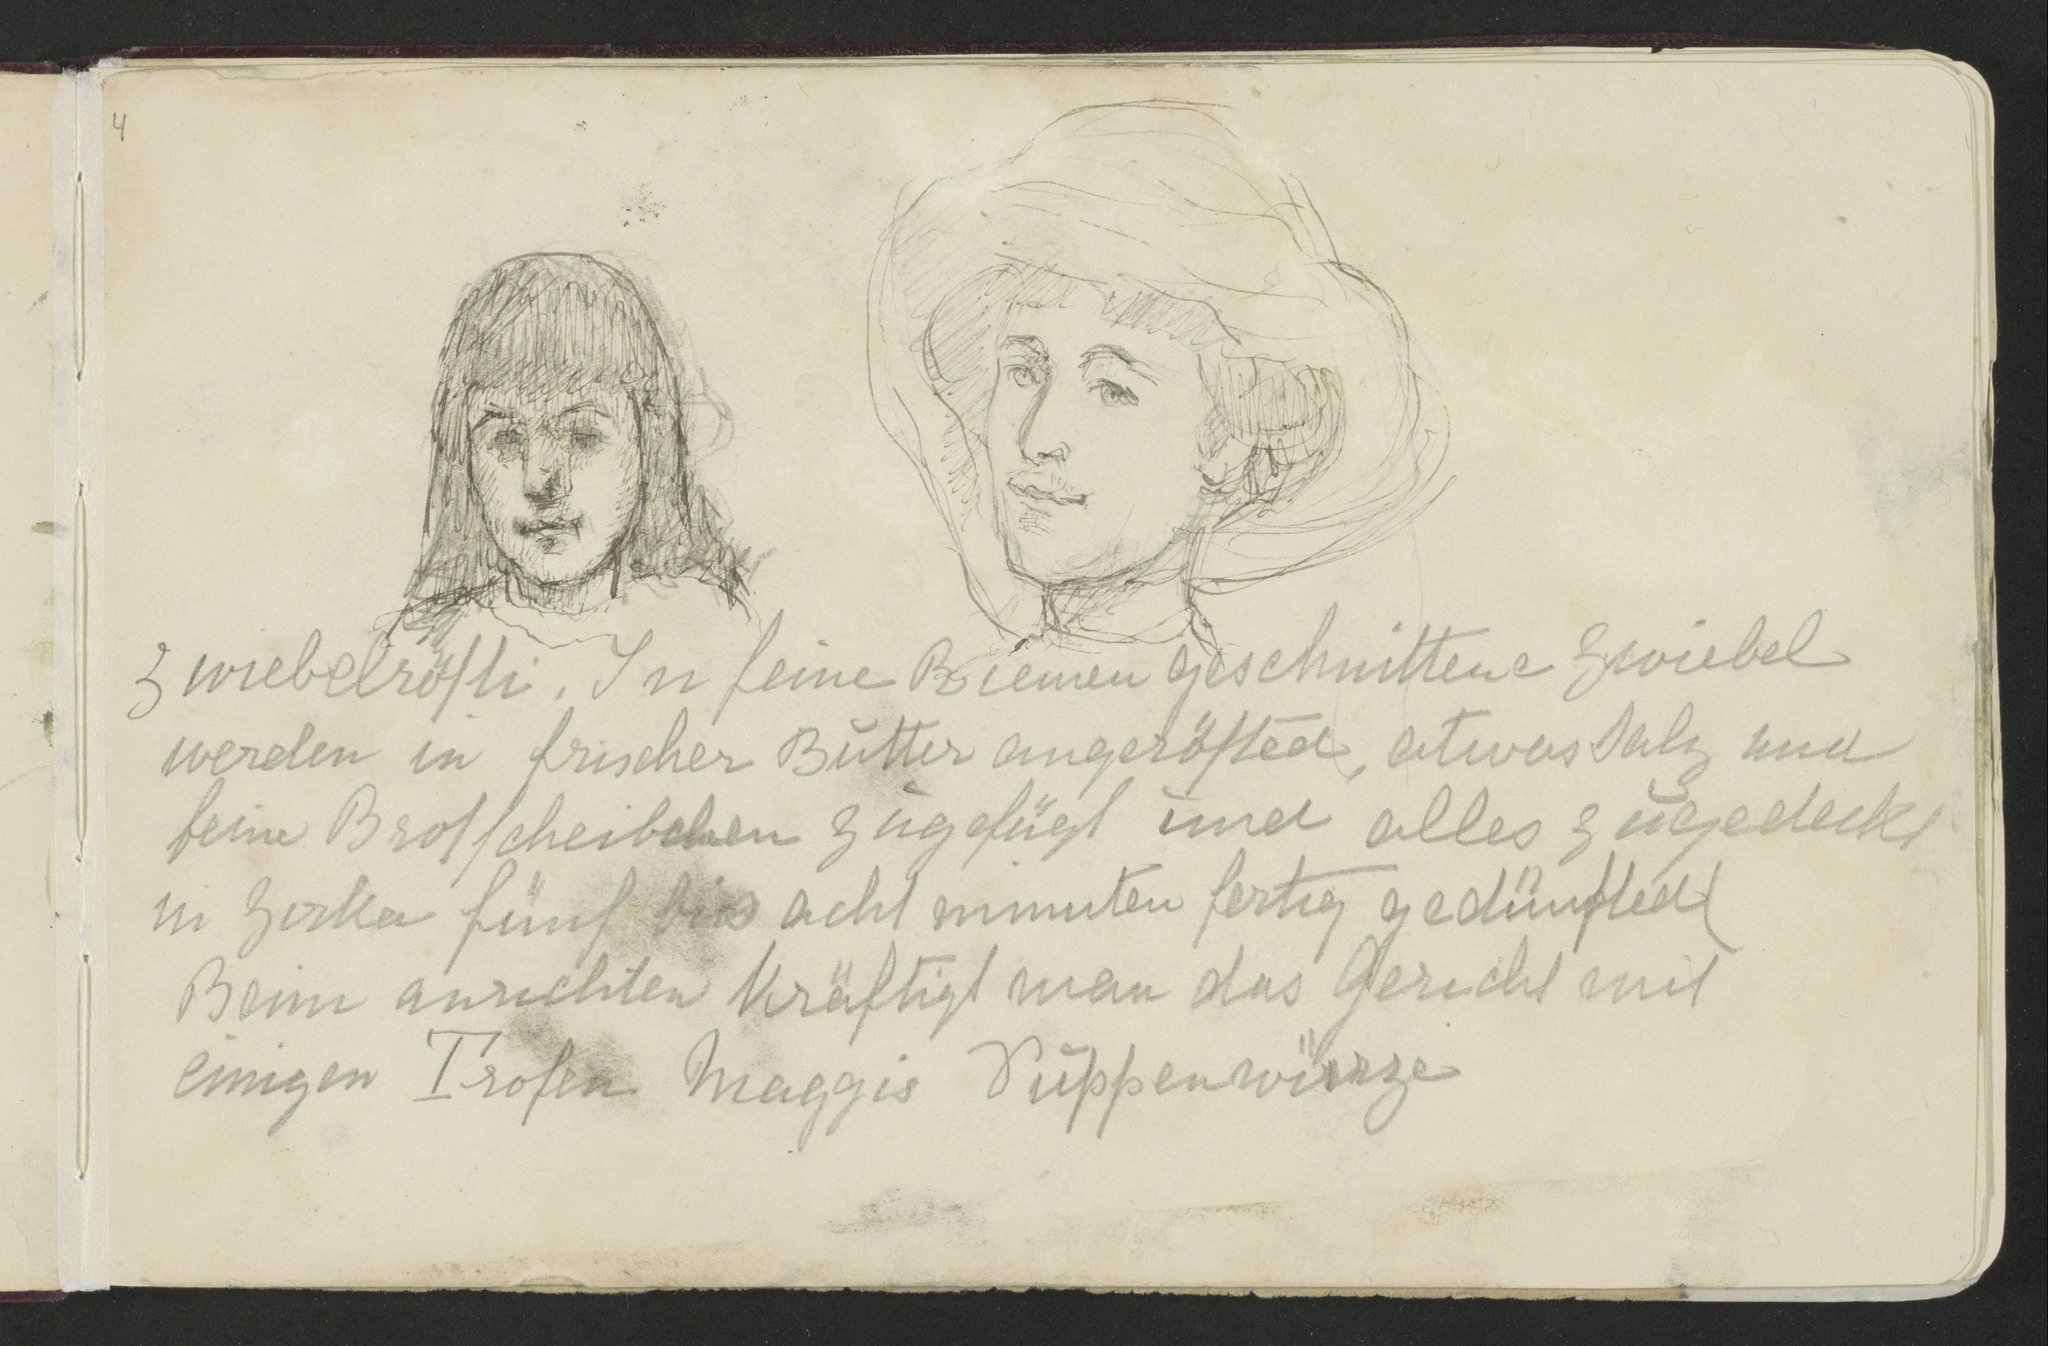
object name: sketchbook leaf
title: Kop van een meisje en van een man met een hoed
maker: jozef israëls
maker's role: draughtsman, painter, print maker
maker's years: 1824-1911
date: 1885-1911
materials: paper, pencil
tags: head (human), girl (child between toddler and youth)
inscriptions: annotation: ‘[...]’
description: Blad 4 recto uit een schetsboek met 26 bladen.